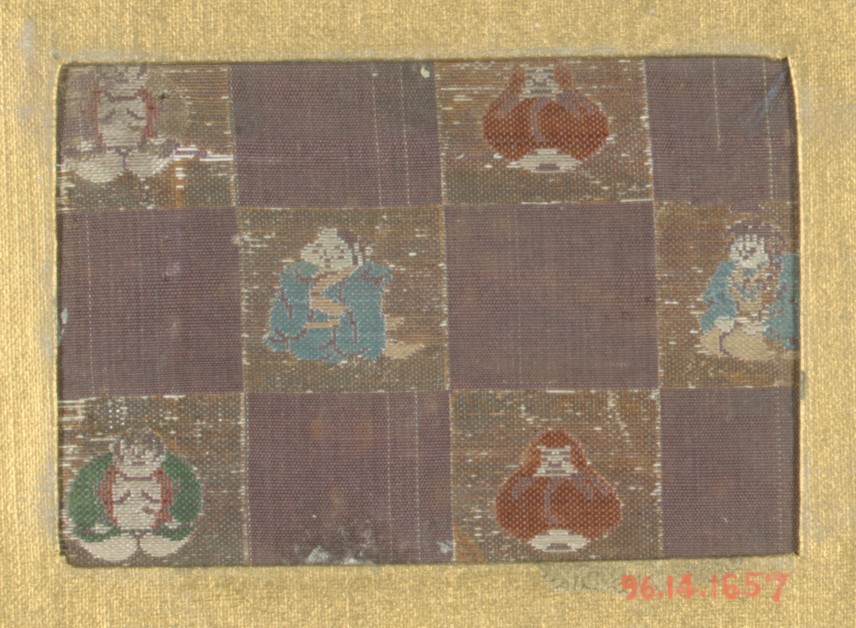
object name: piece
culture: japanese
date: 1701-1900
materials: silk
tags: human figures